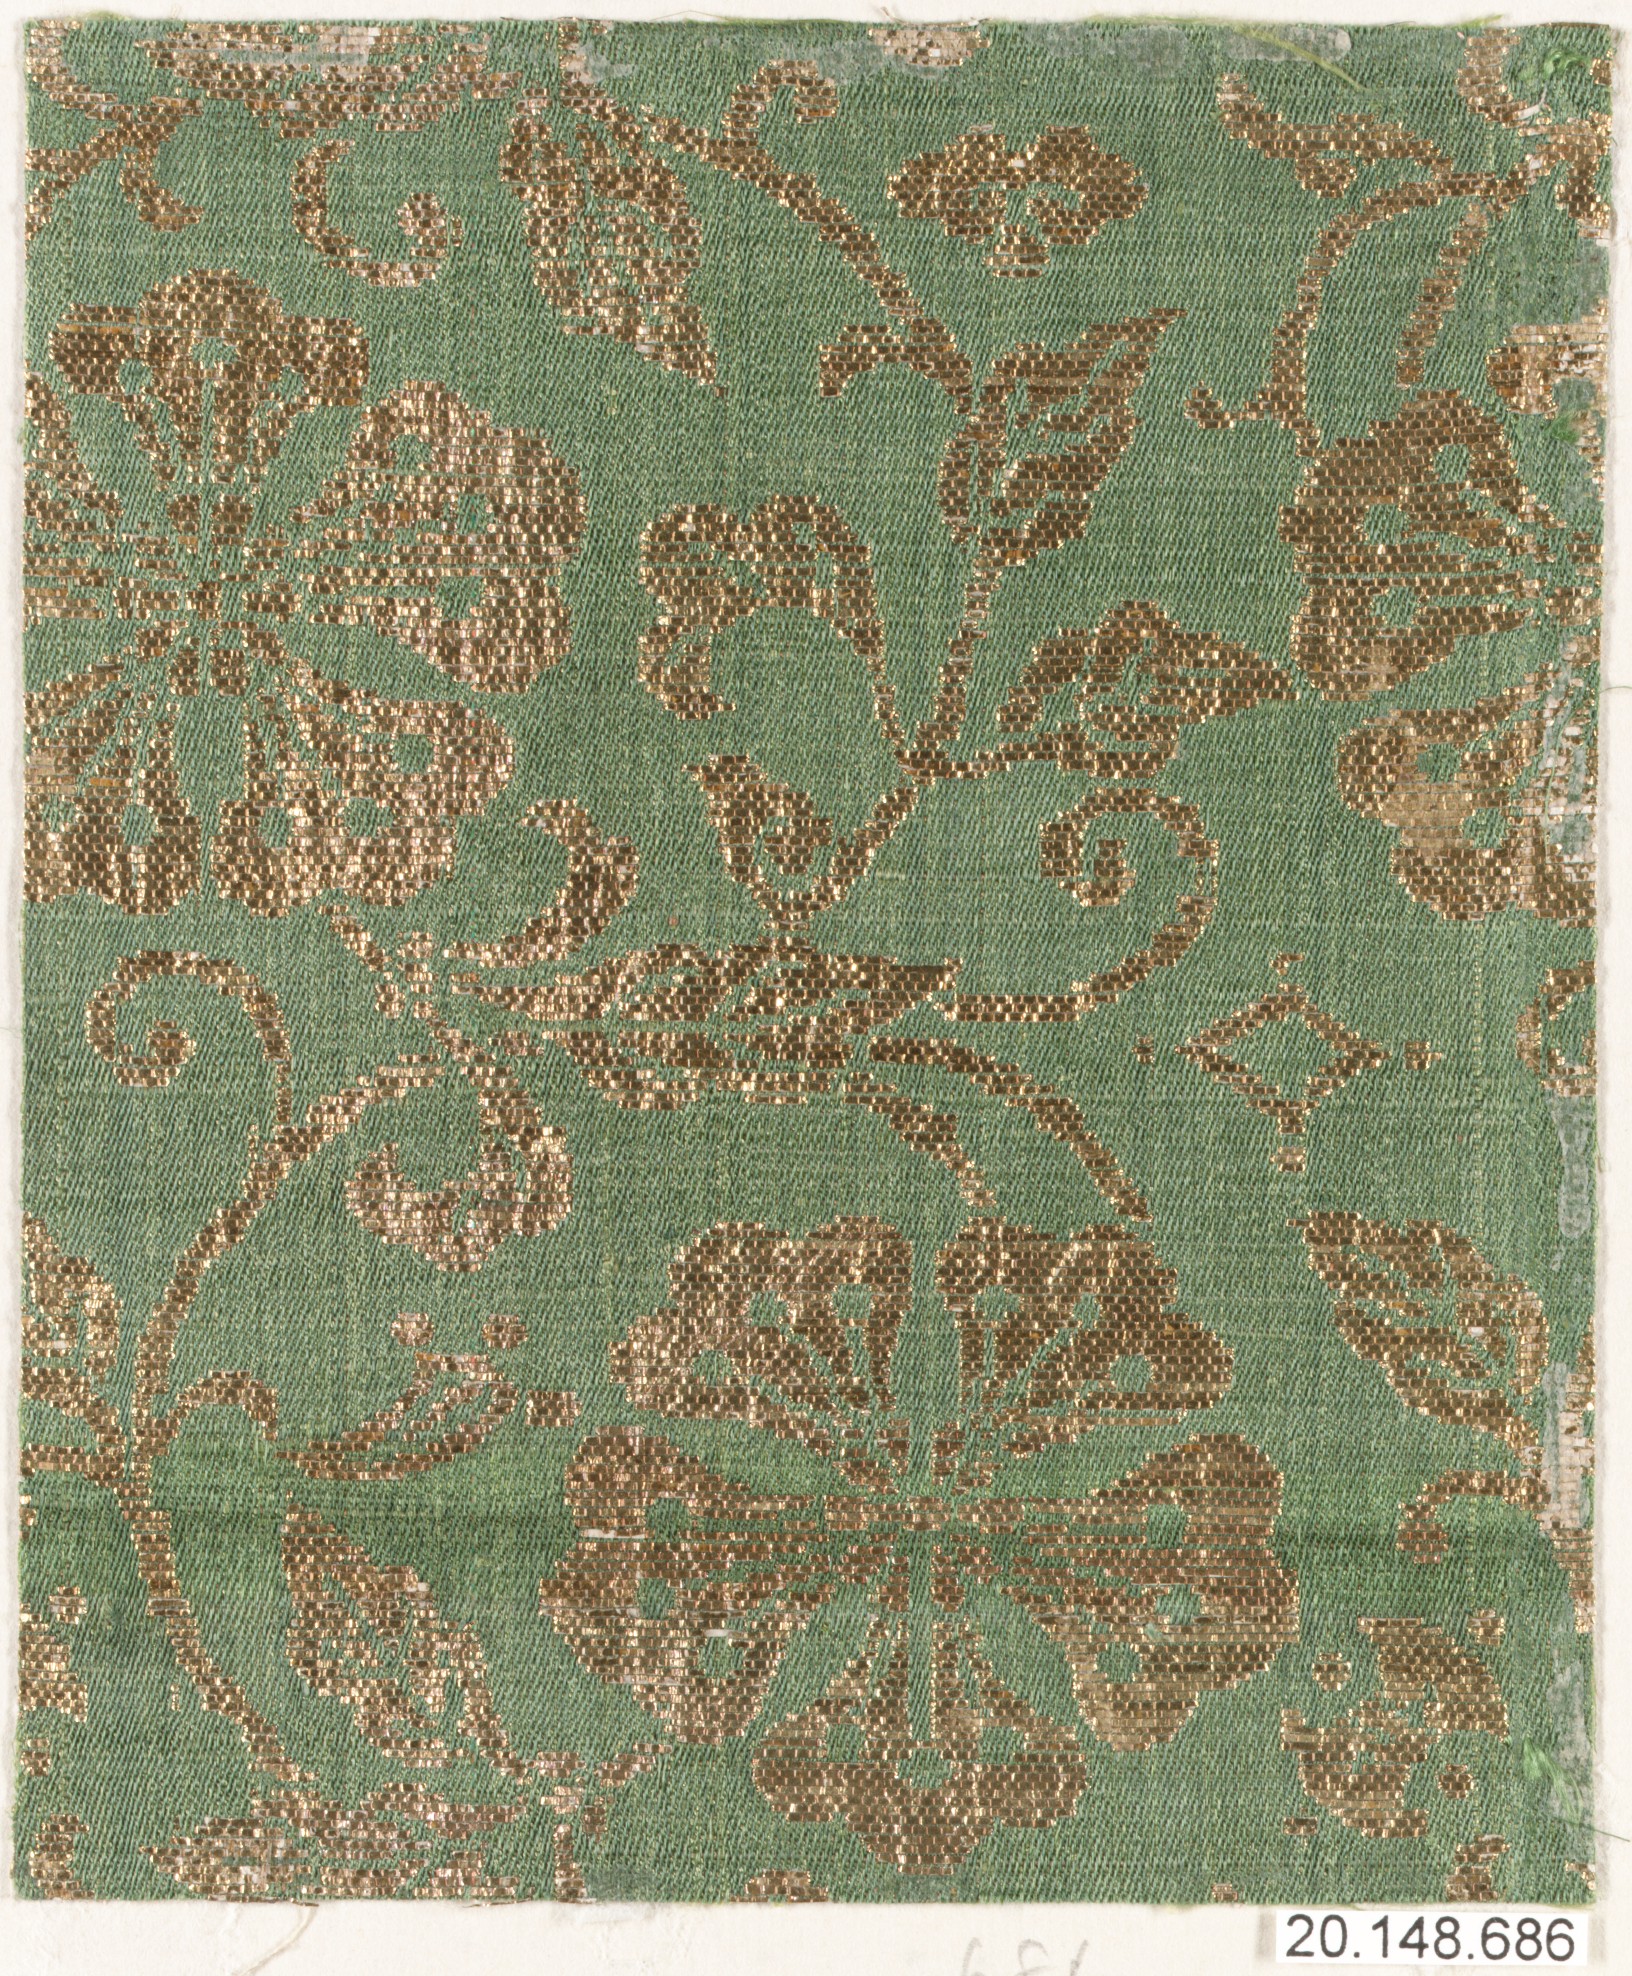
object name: piece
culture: japanese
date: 1601-1700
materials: silk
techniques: compound weave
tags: flowers,leaves